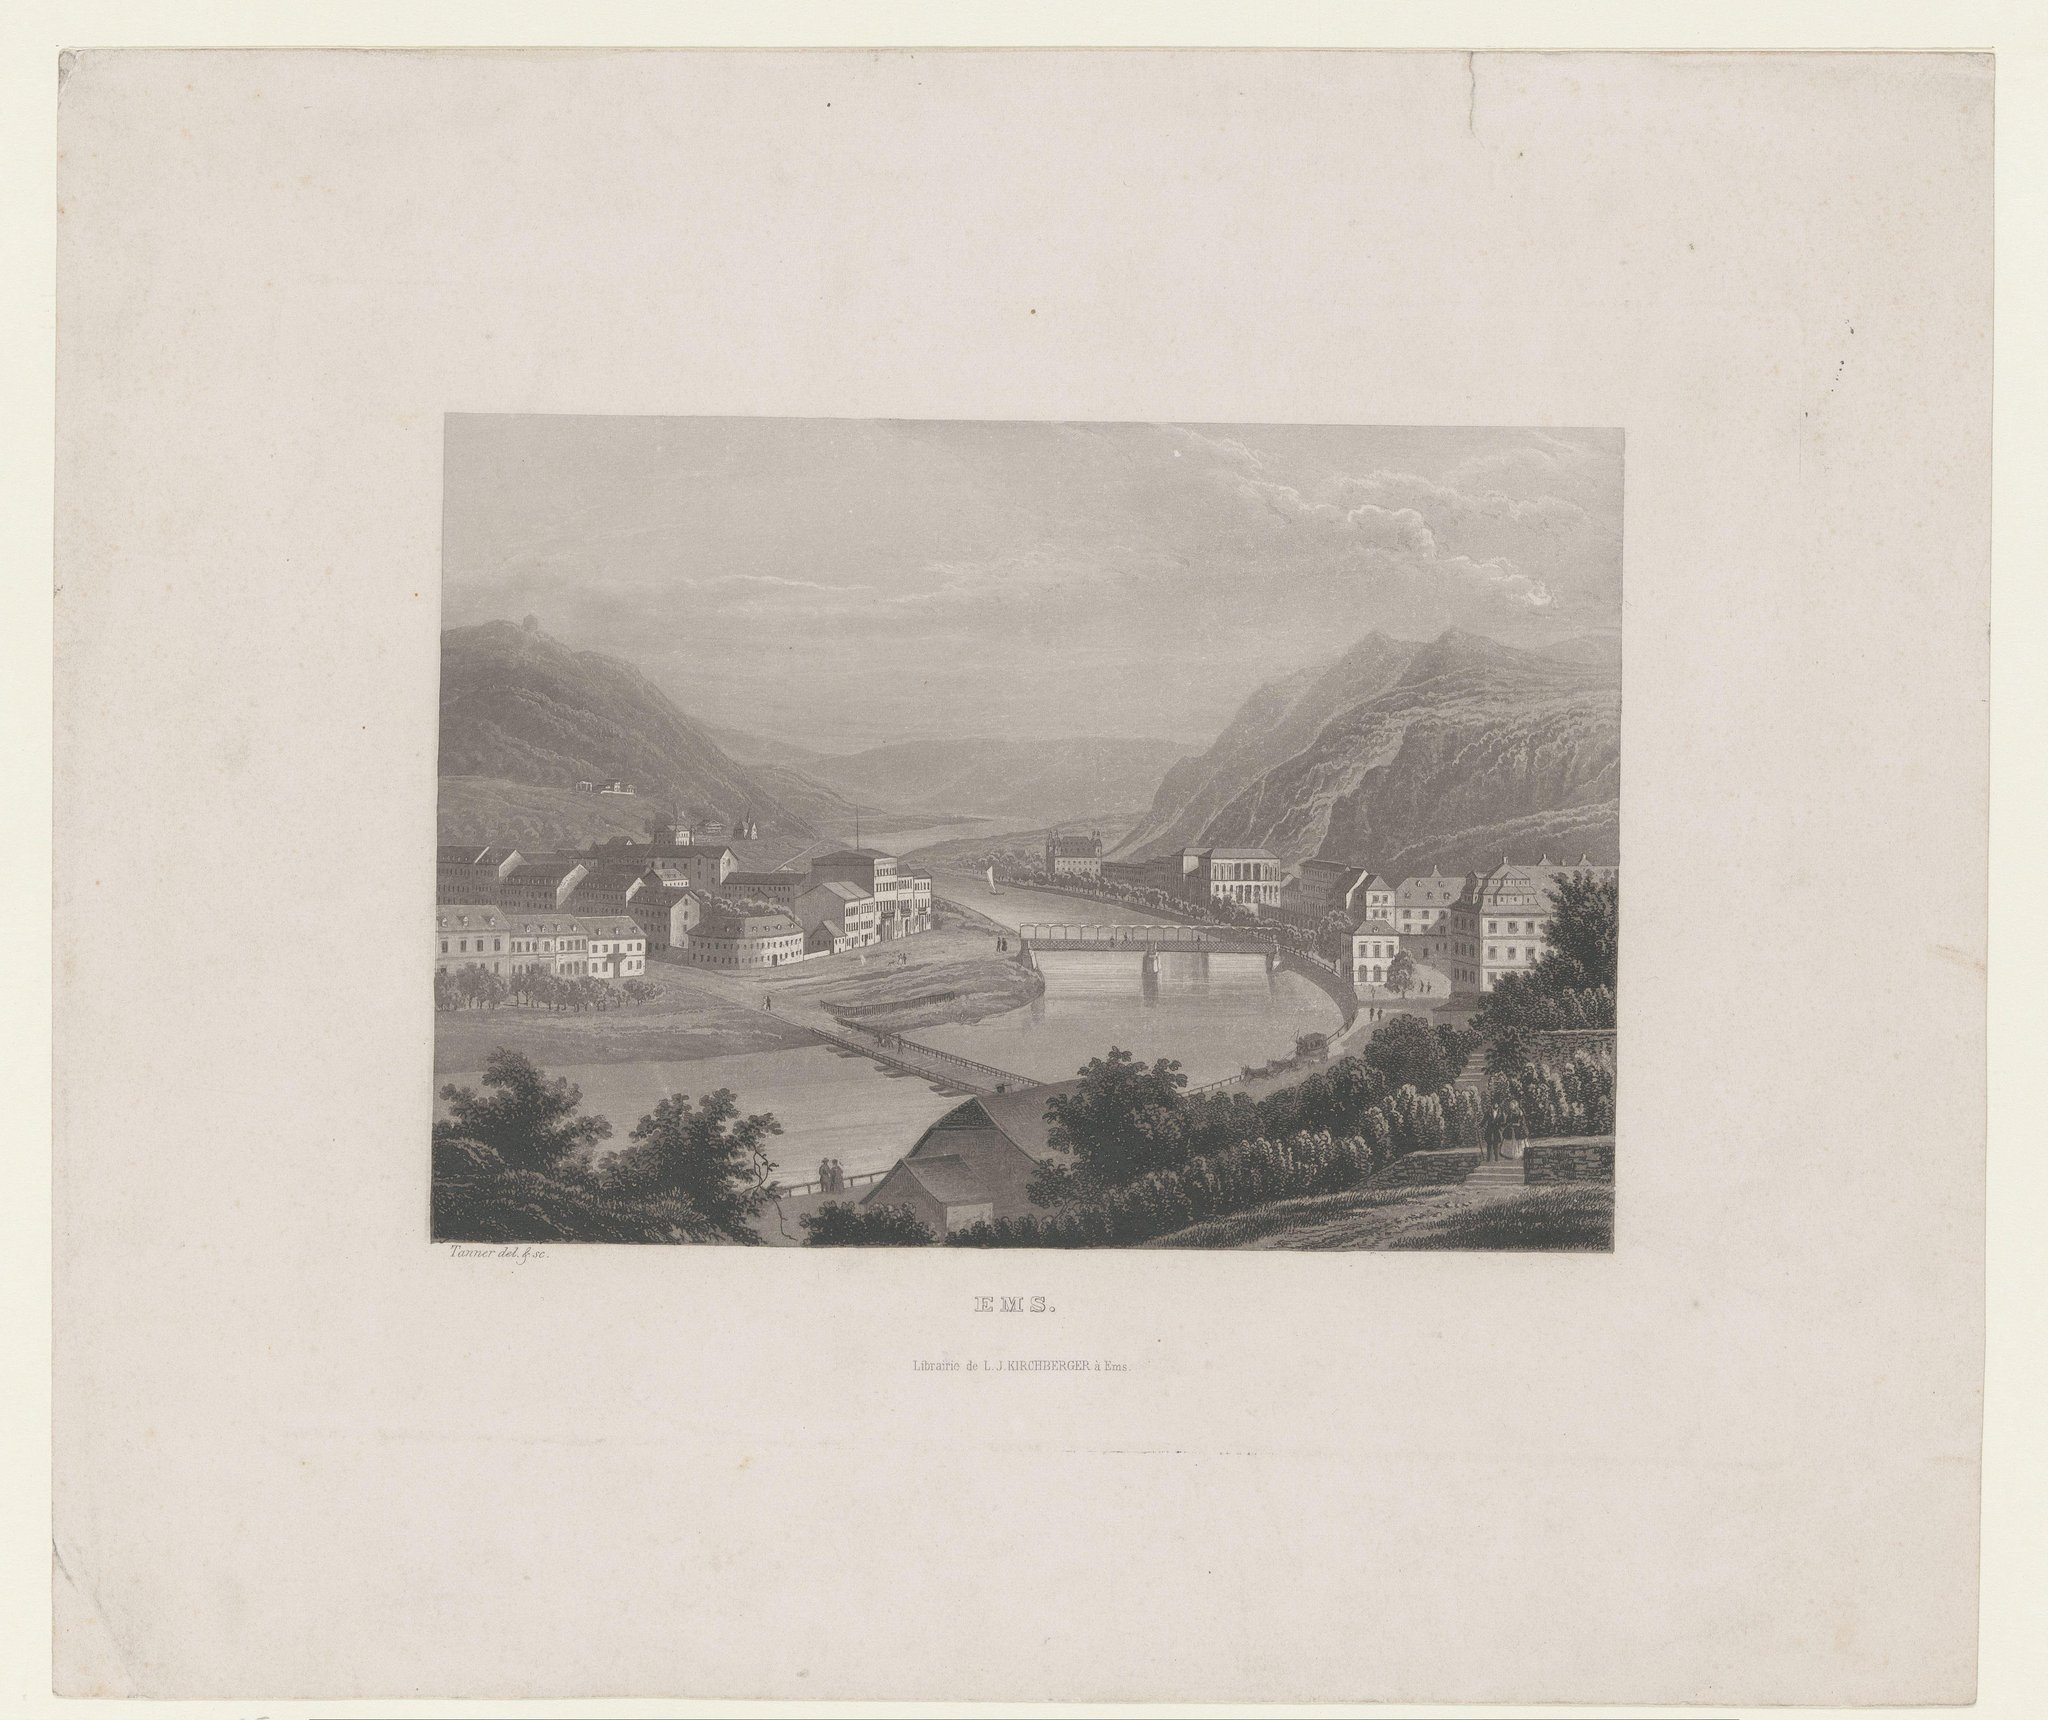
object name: print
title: Ems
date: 1850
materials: paper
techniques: aquatint, etching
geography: bad ems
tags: prospect of village, silhouette of village, river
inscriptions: collector's mark: Lugt 2228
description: Prent ook gebruikt in: Erinnerung an Ams. Bad Ems: L.J. Kirchberger, [ca. 1750].